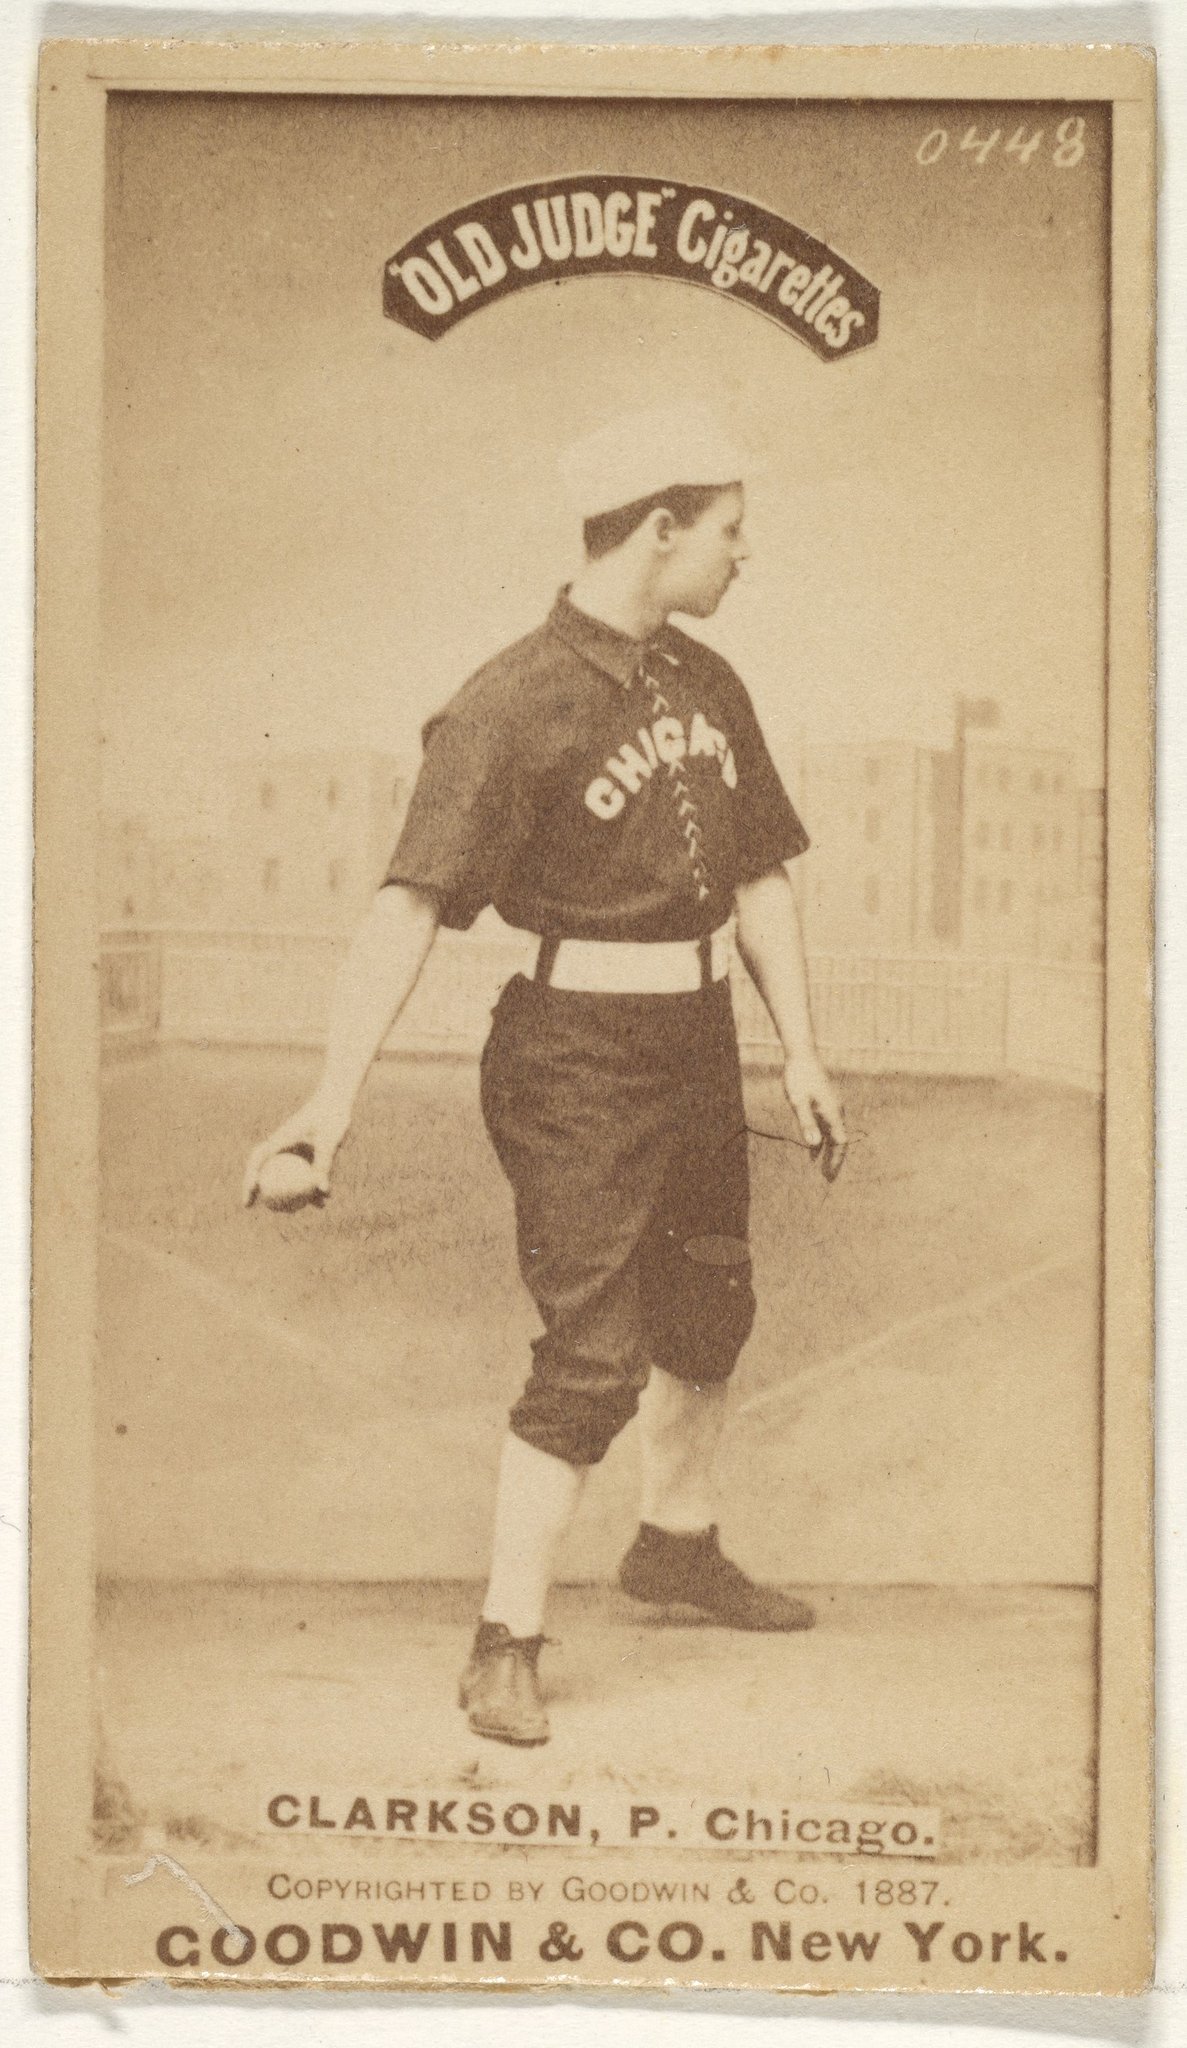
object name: baseball card, photograph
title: Clarkson, Pitcher, Chicago, from the Old Judge series (N172) for Old Judge Cigarettes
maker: goodwin & company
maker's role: publisher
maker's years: 1850-1950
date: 1887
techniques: albumen silver print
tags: men,portraits,baseball,athletes